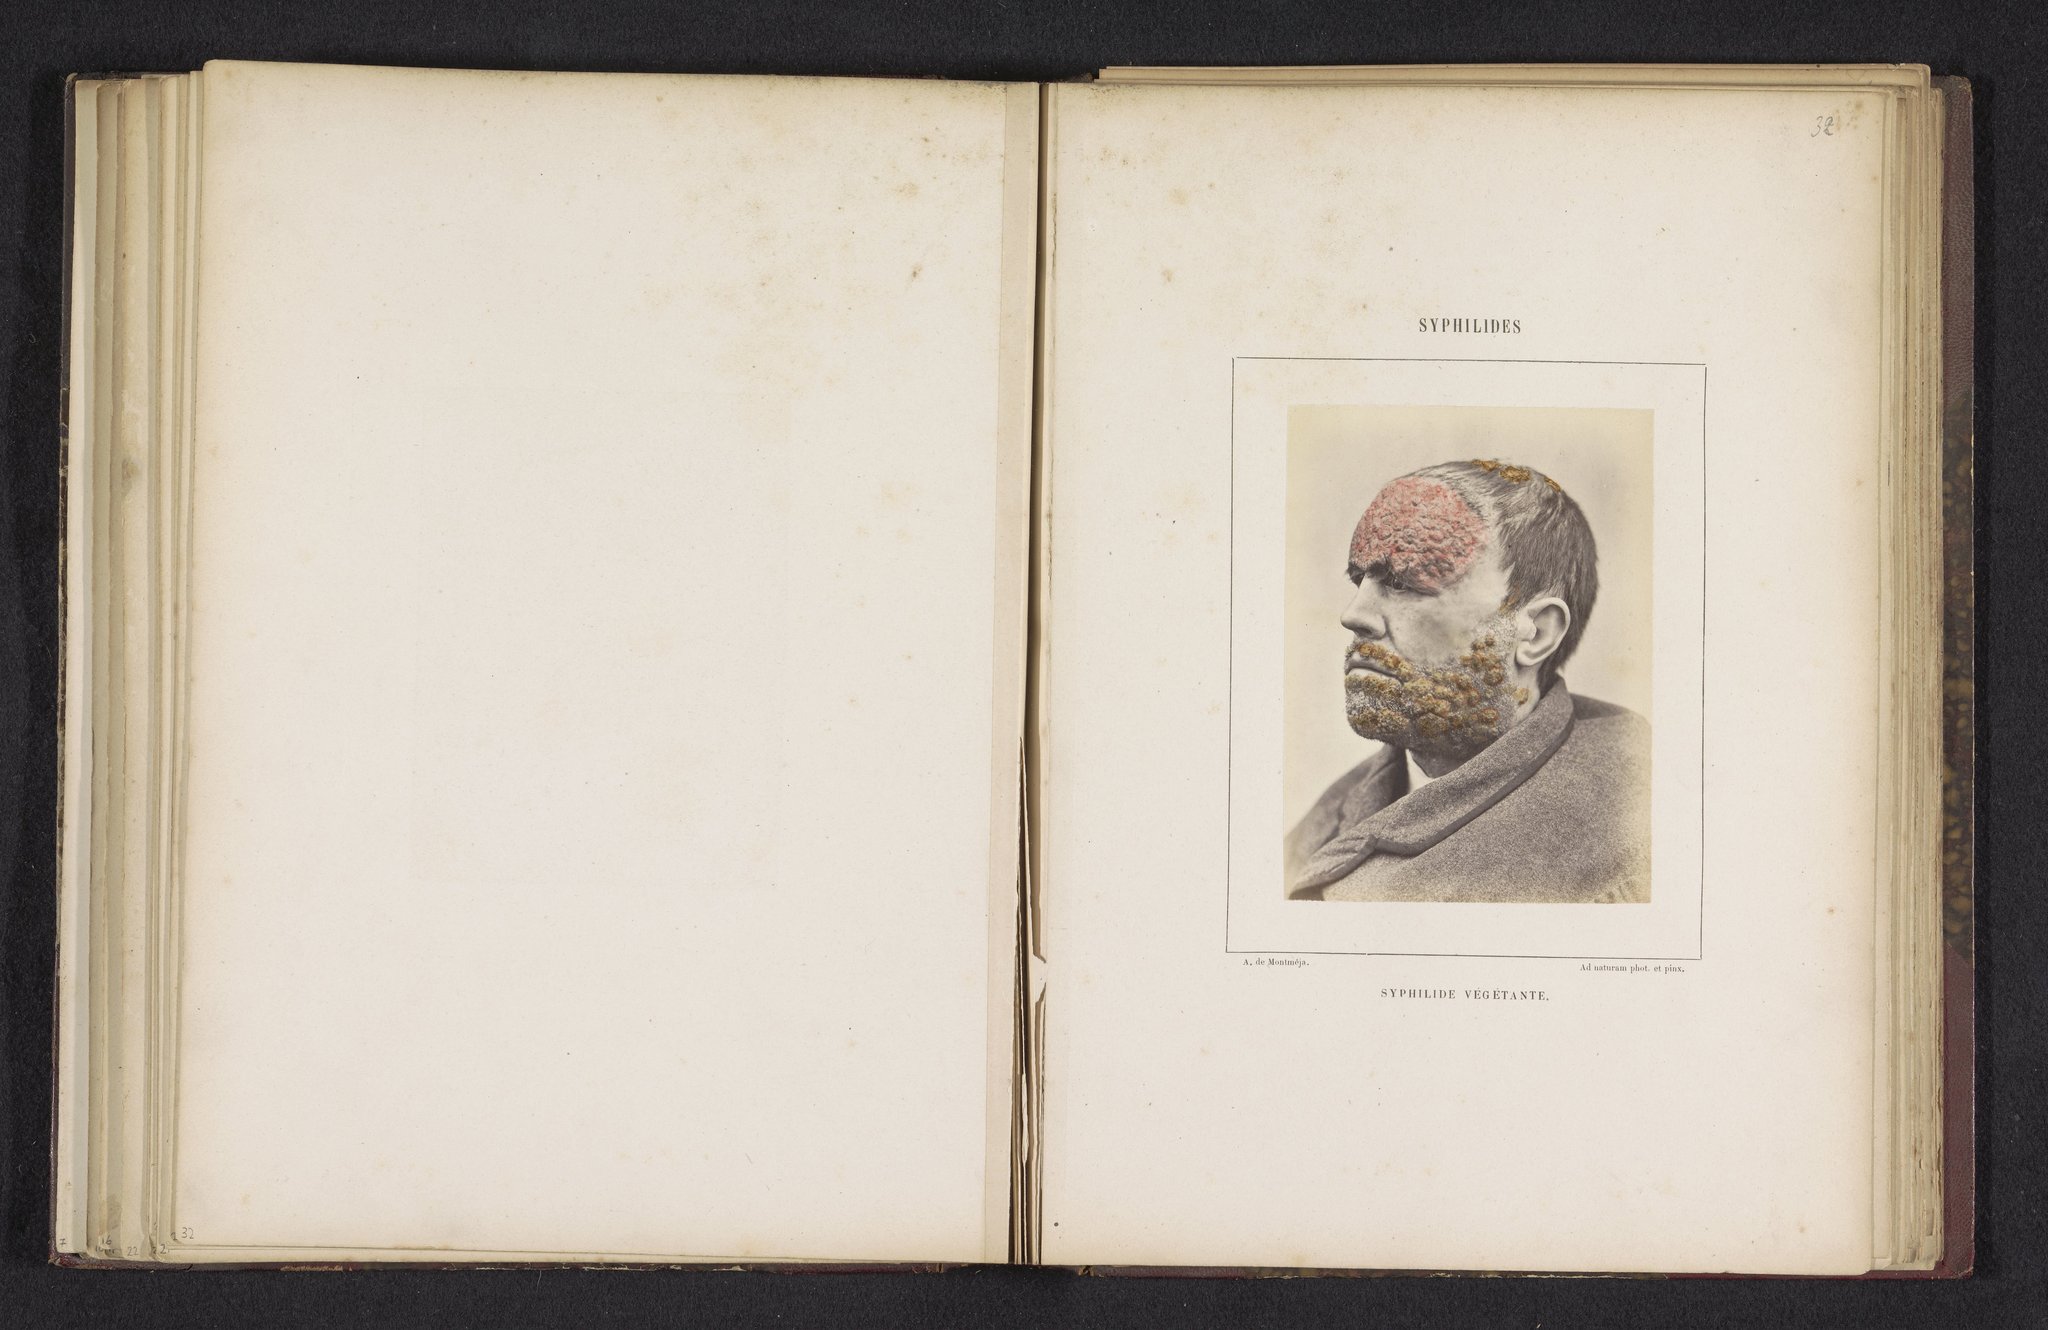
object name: page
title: Syphilide végétante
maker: a. de montméja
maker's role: arts, fotograaf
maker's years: 1841-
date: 1860-1868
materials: photographic support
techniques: albumen print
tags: skin and venereal diseases: syphilis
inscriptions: inscription: ‘Syphilides’, inscription: ‘Ad naturam phot. et pinx.’, number: ‘32’